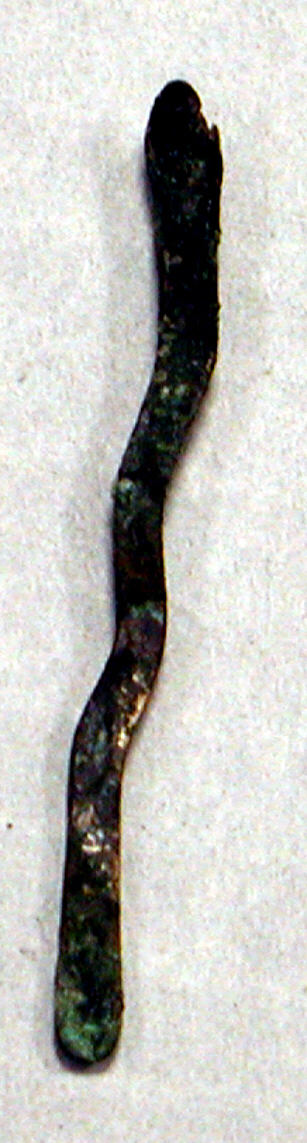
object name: lime spoon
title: Copper Lime Spoon in Snake Form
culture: inca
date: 1401-1600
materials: copper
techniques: casting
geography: peru